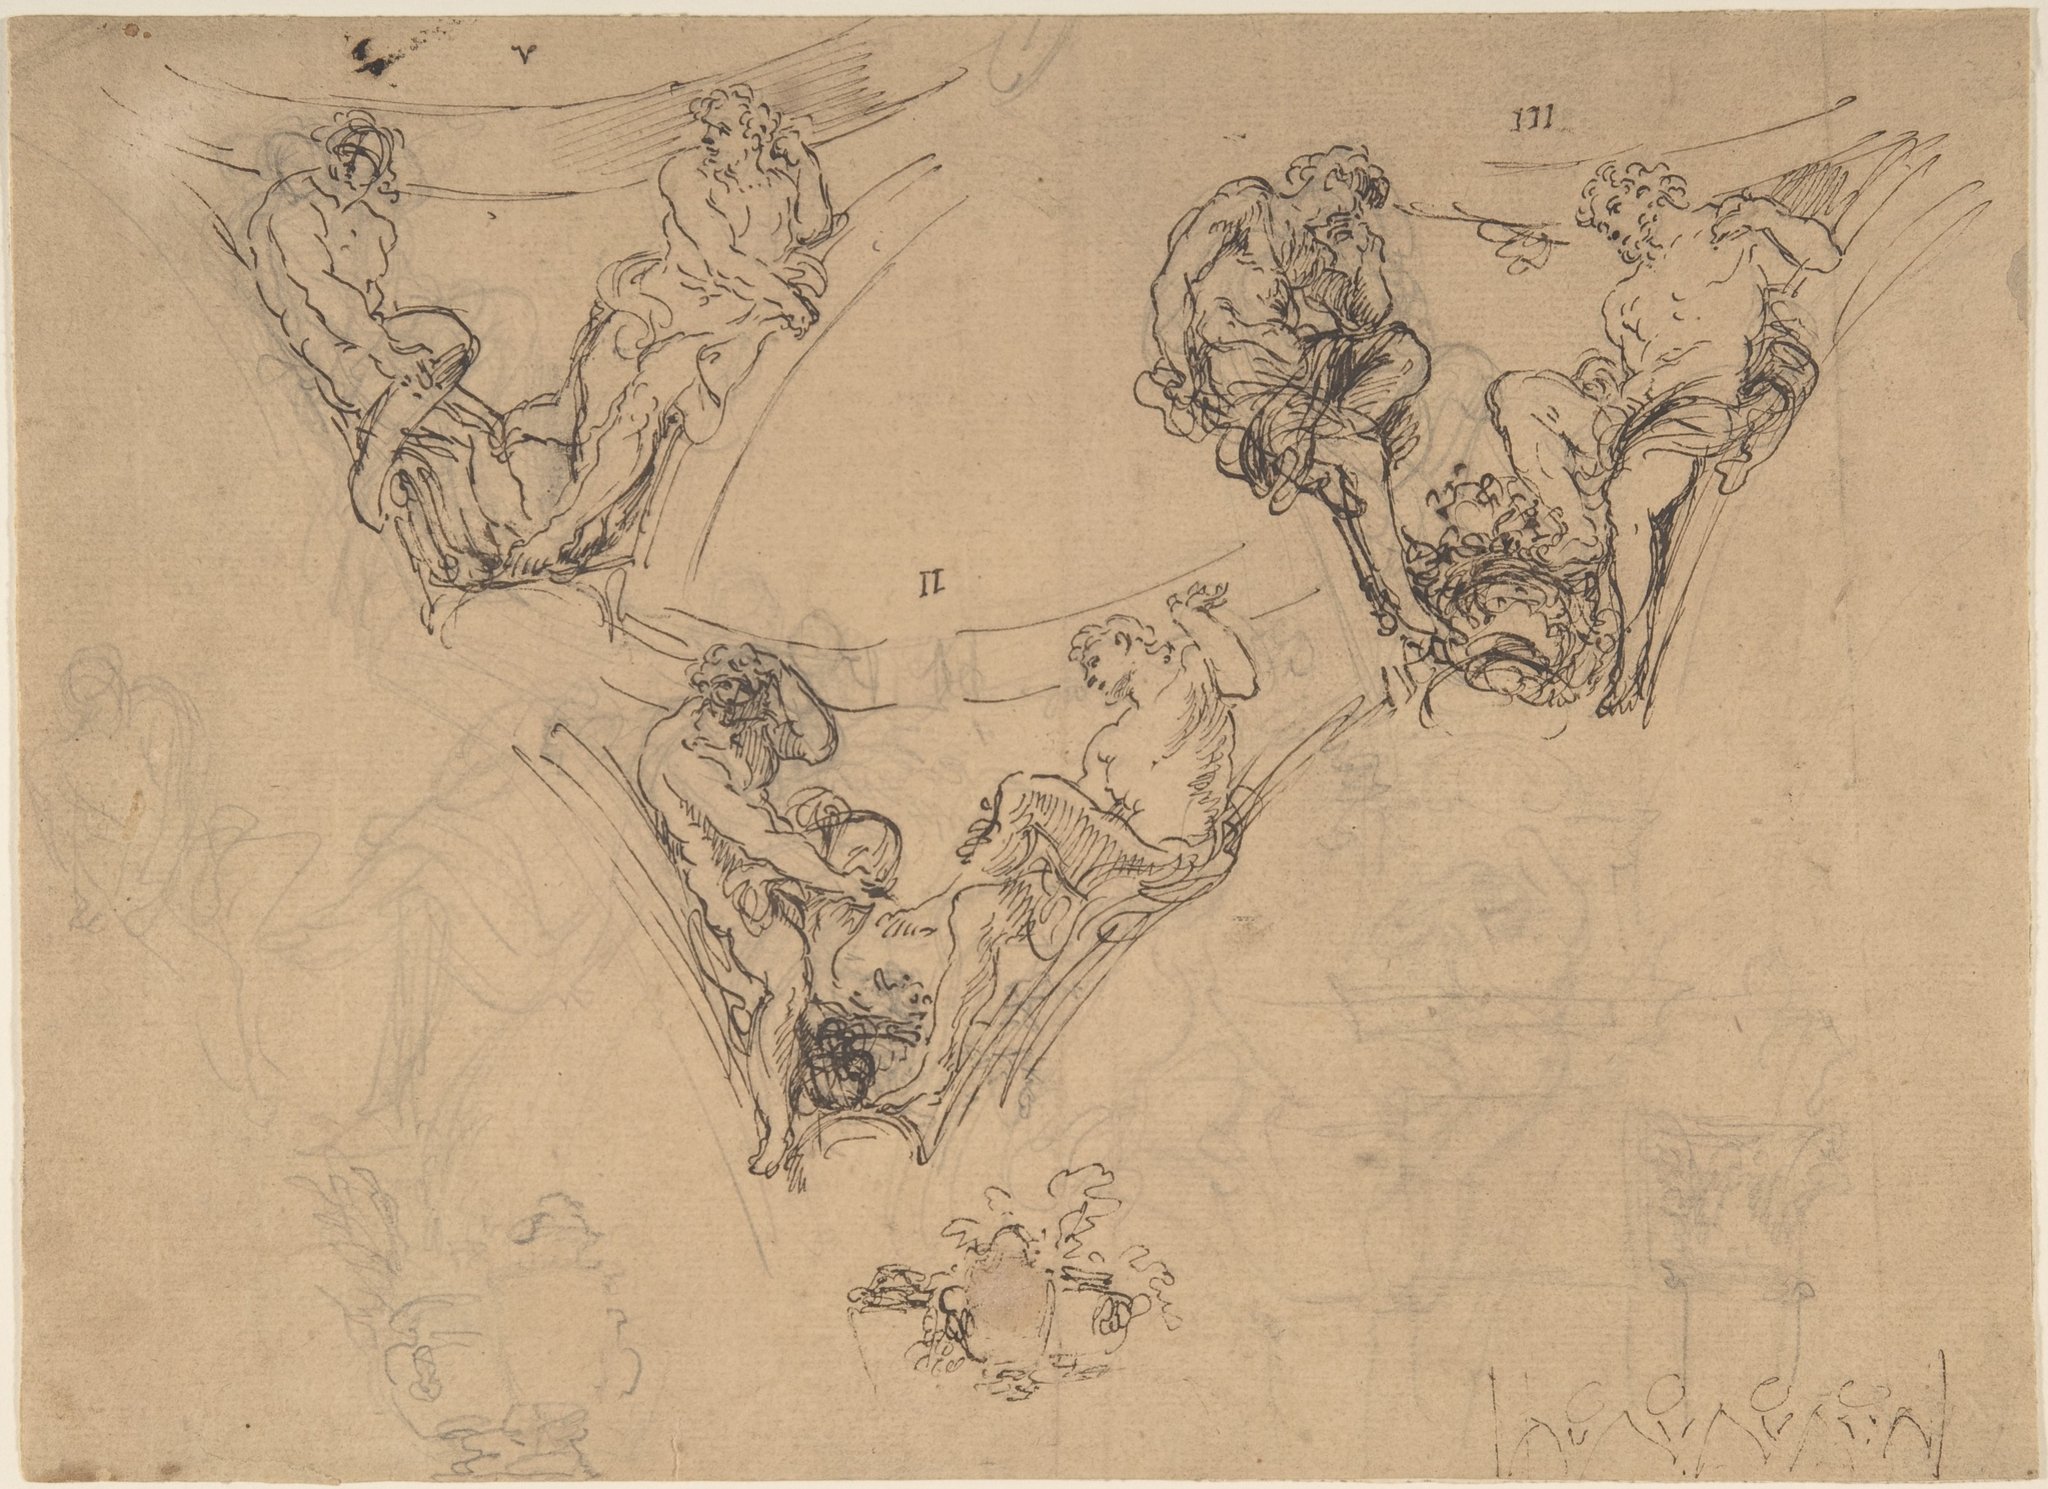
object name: drawing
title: Three Studies for Spandrel Figures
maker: anonymous, italian, 17th century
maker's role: artist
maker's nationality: italian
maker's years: 1600-1700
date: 1601-1700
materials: graphite, ink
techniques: pen, drawing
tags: male nudes